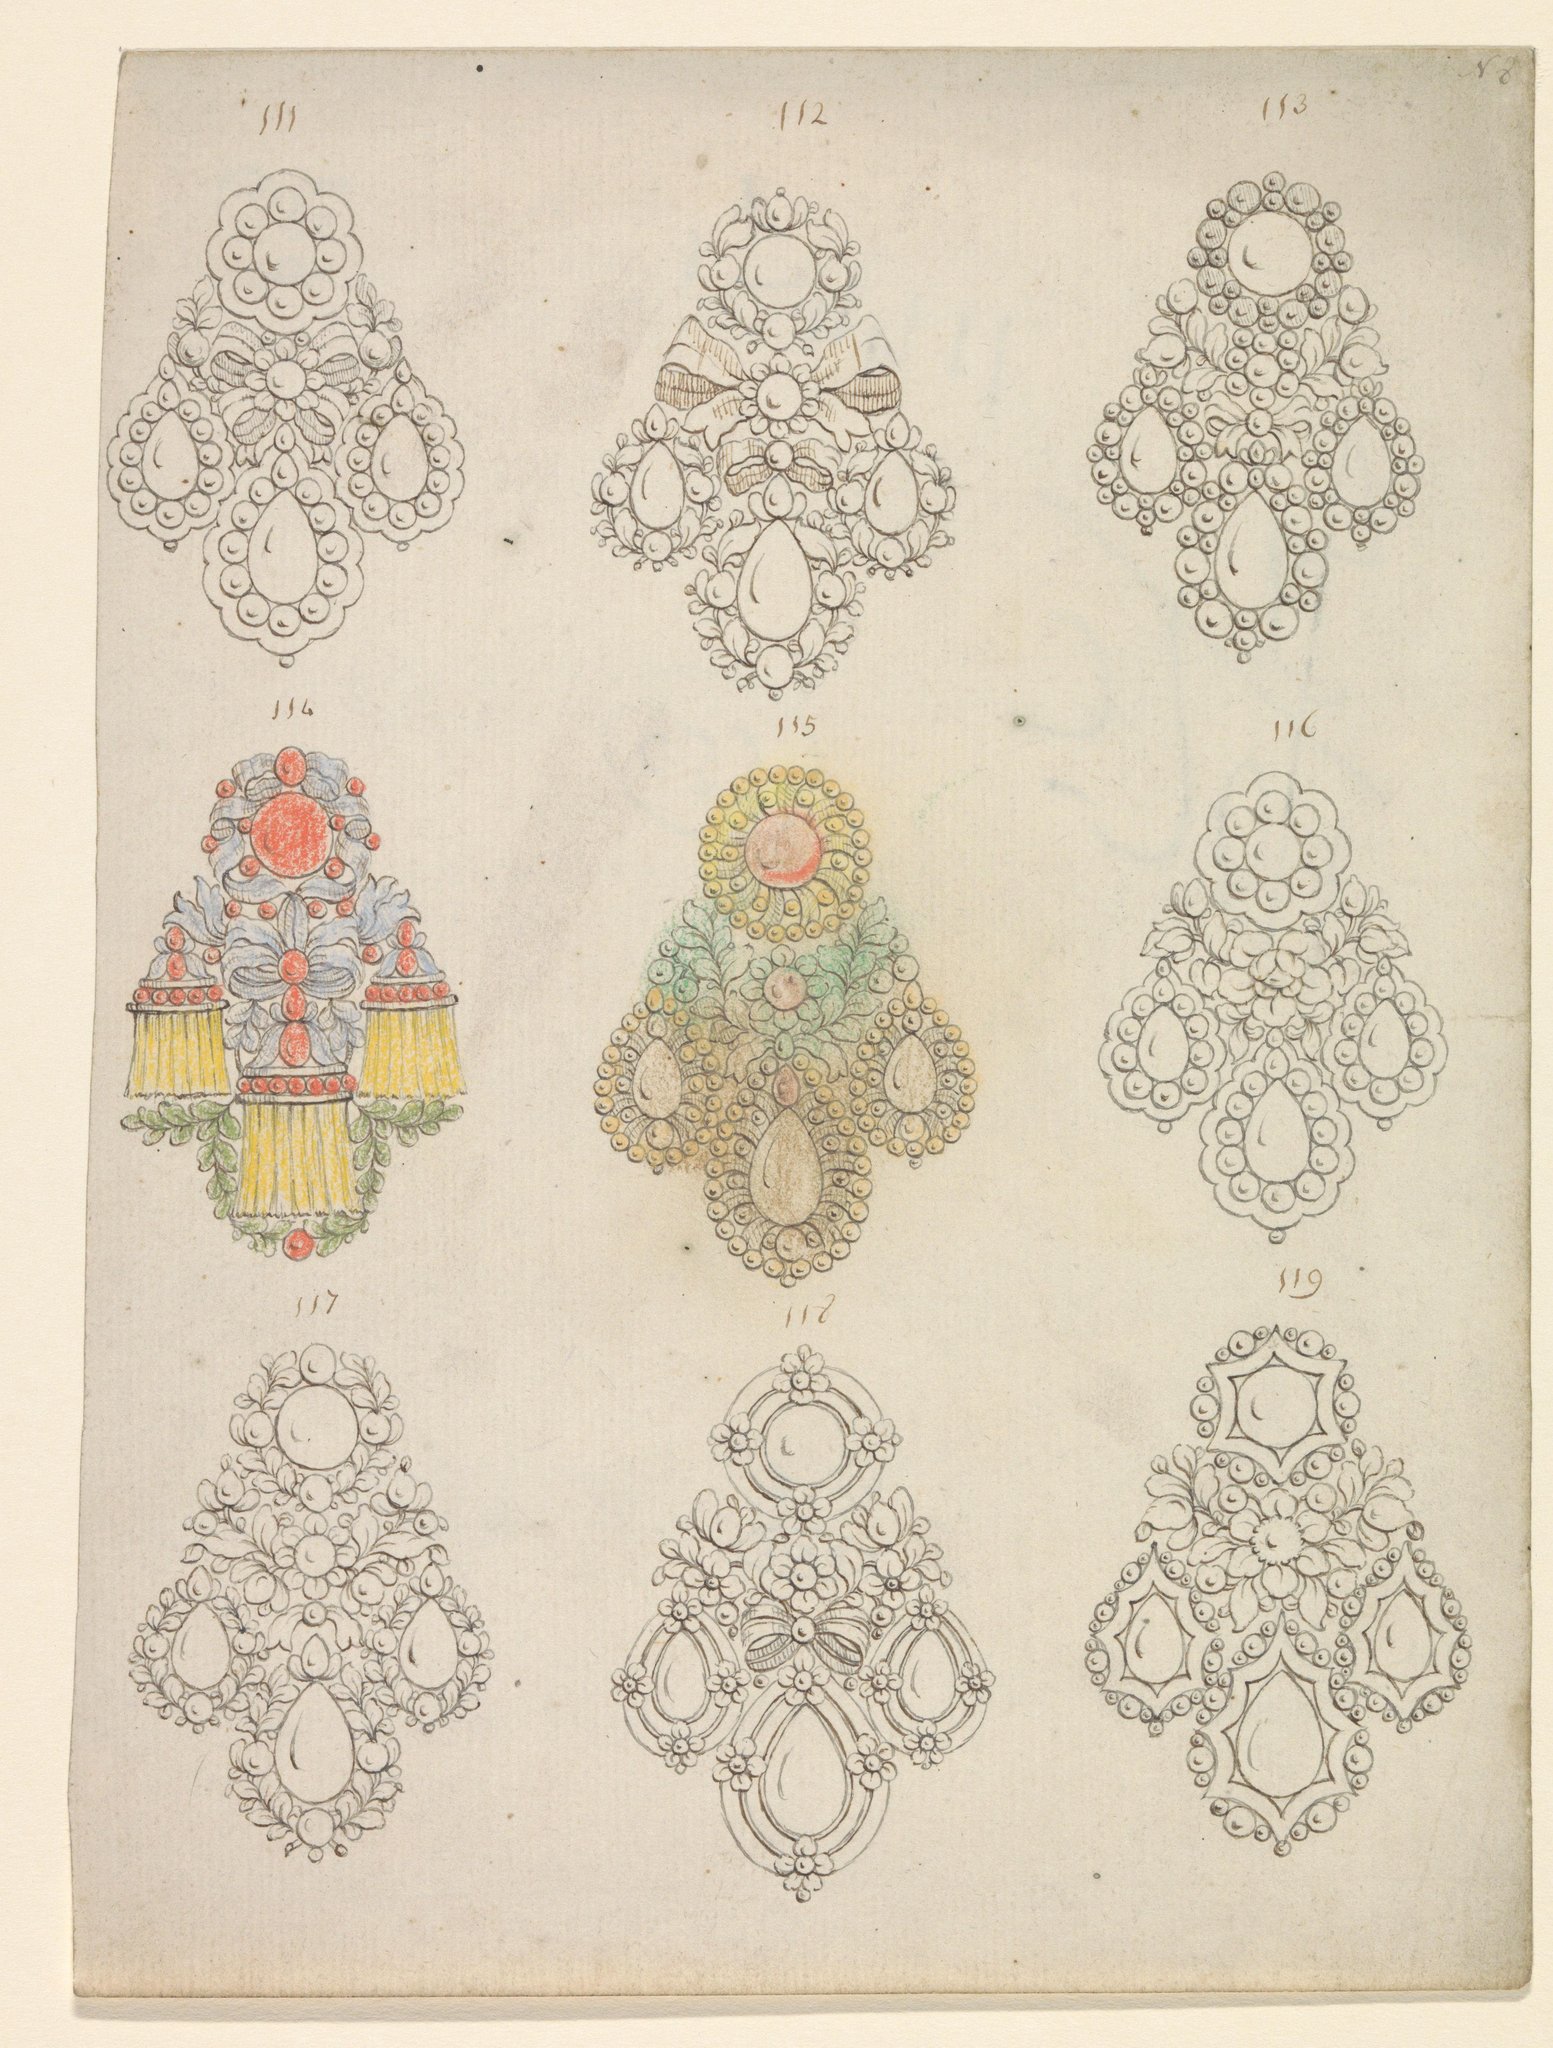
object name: drawing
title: Oorbellen of broches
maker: Anonymous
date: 1750-1780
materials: chalk, ink, paper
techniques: pen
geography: france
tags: brooch, agraffe, clasp, ear-rings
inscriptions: collector's mark: Lugt 2228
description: Ontwerpen van negen oorbellen of broches met parels, strikken en bloemmotieven, met nummering 111 tot en met 119.